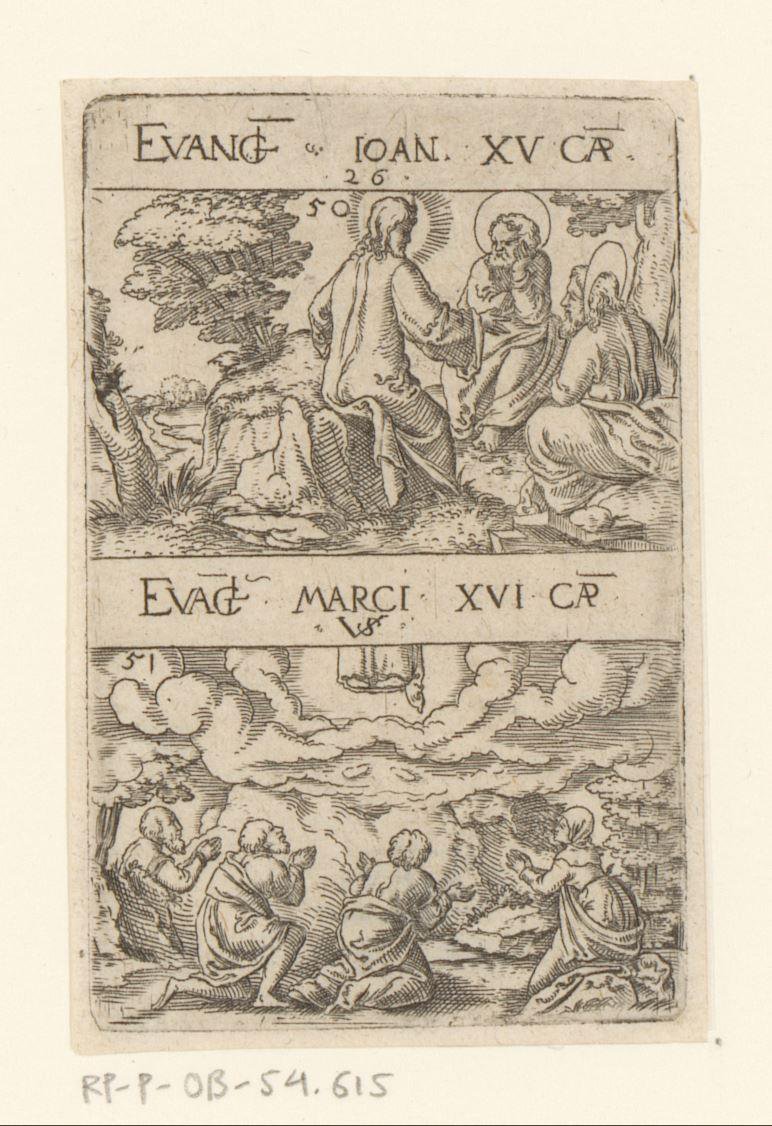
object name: print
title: Christus spreekt tot zijn discipelen en de hemelvaart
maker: virgilius solis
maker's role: draughtsman, print maker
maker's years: 1514-1562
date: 1524-1562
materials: paper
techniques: engraving, etching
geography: nuremberg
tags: christ addressing his disciples after the last supper (john 14-16), christ almost vanished: only feet visible ~ ascension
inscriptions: number: ‘88’, collector's mark: Lugt 2228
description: Deze prent maakt deel uit van een serie bestaande uit 27 genummerde prenten. De prenten tonen steeds twee evangelische scènes boven elkaar. Alle voorstellingen behalve de bovenste van de eerste prent zijn eveneens afzonderlijk genummerd.